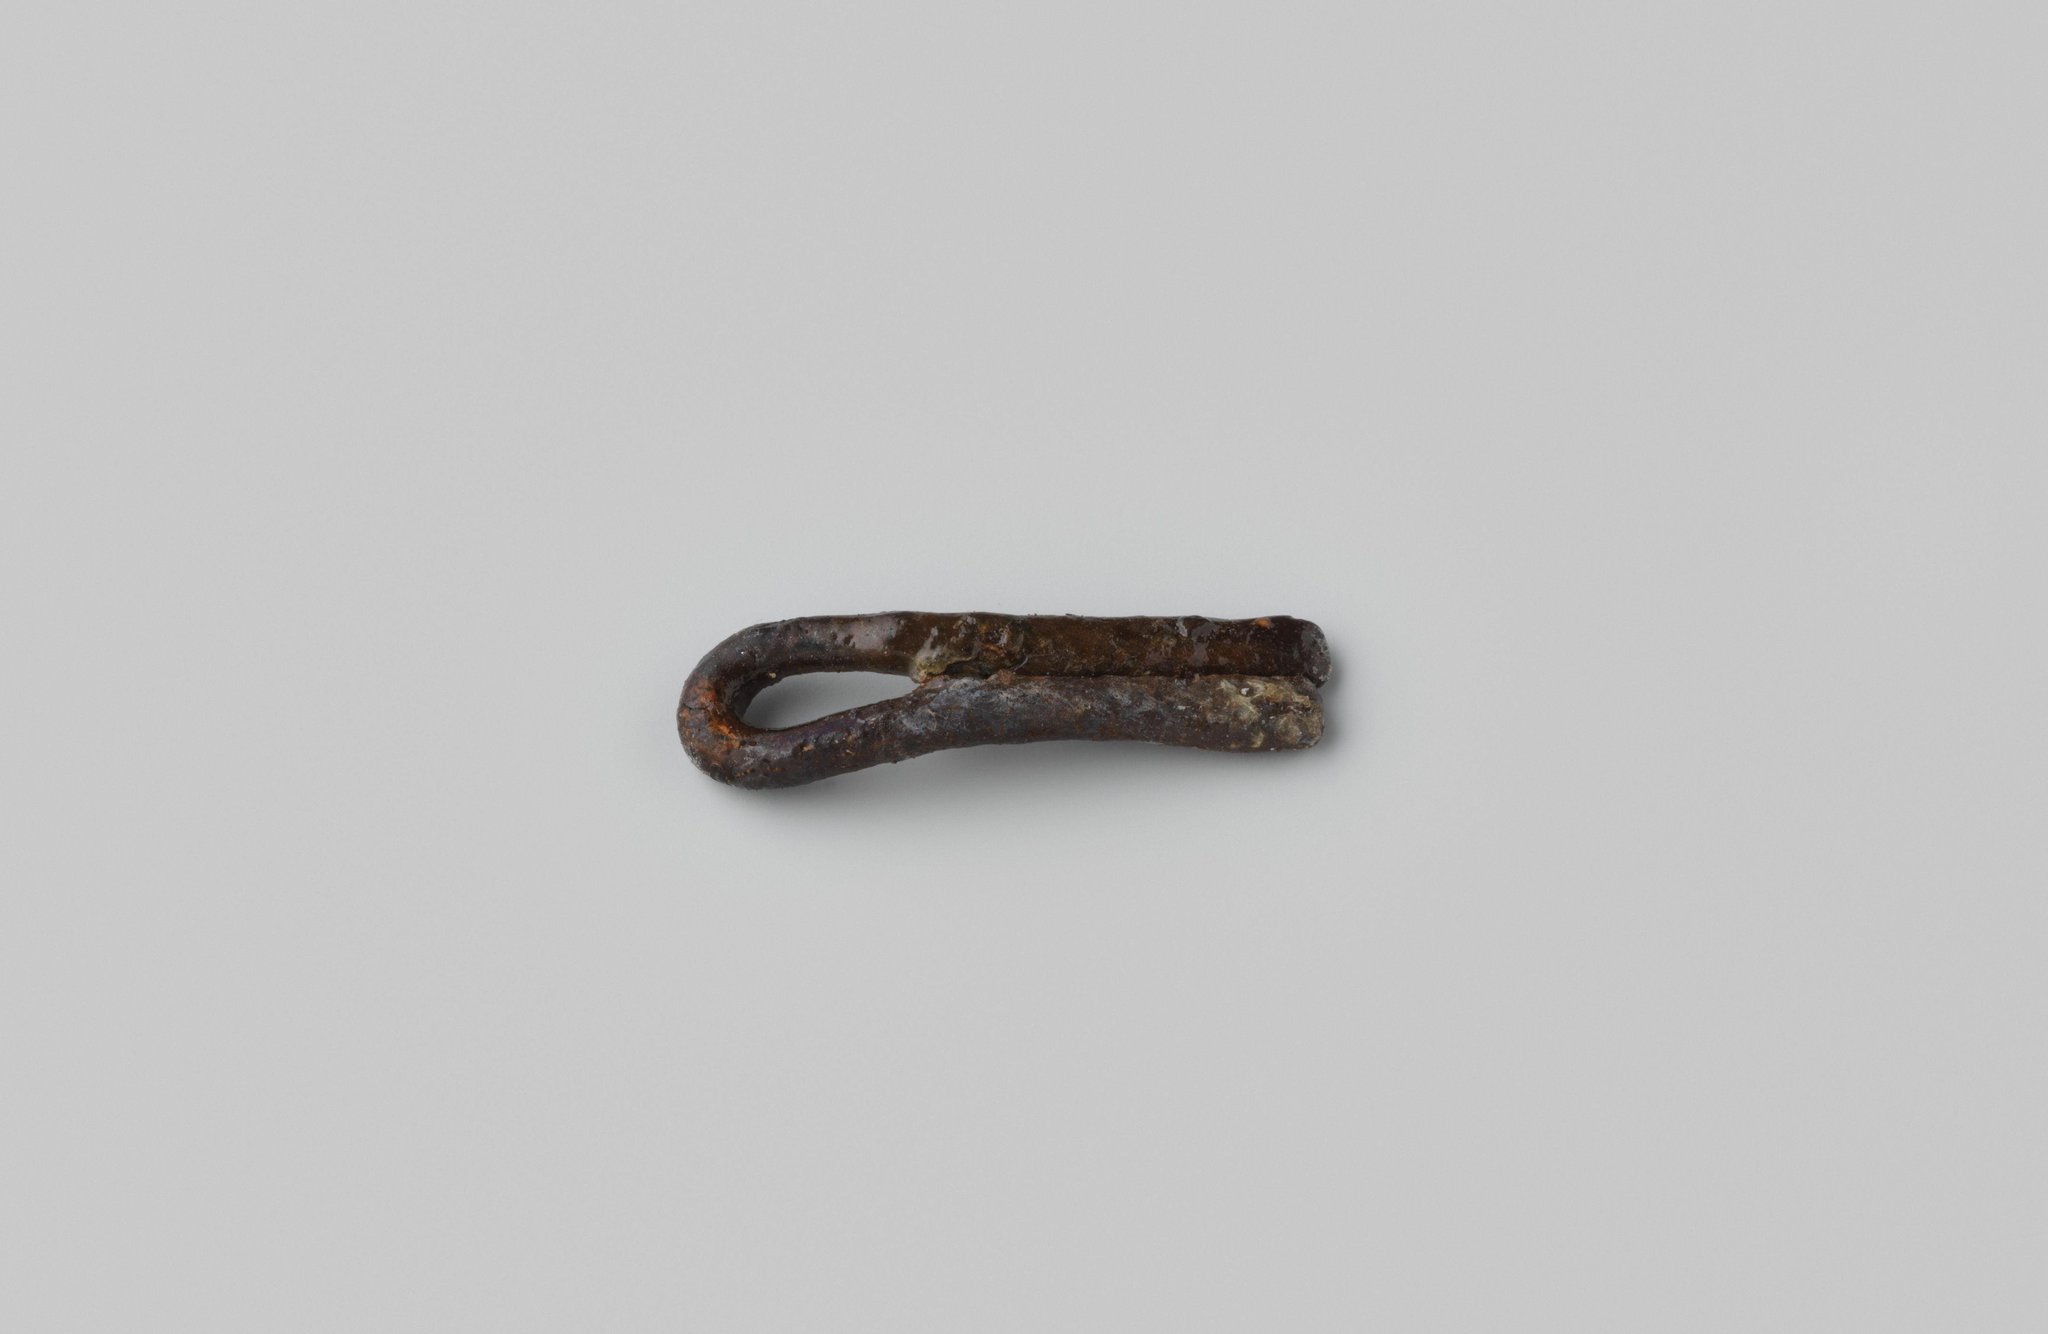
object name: cotter pin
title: Splitpen afkomstig uit het wrak van de Oost-Indiëvaarder Hollandia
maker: Anonymous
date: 1700-1743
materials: copper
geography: netherlands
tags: verenigde oostindische compagnie, hollandia (schip)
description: Split tang; wire, looped circular upper end, straight tongs.